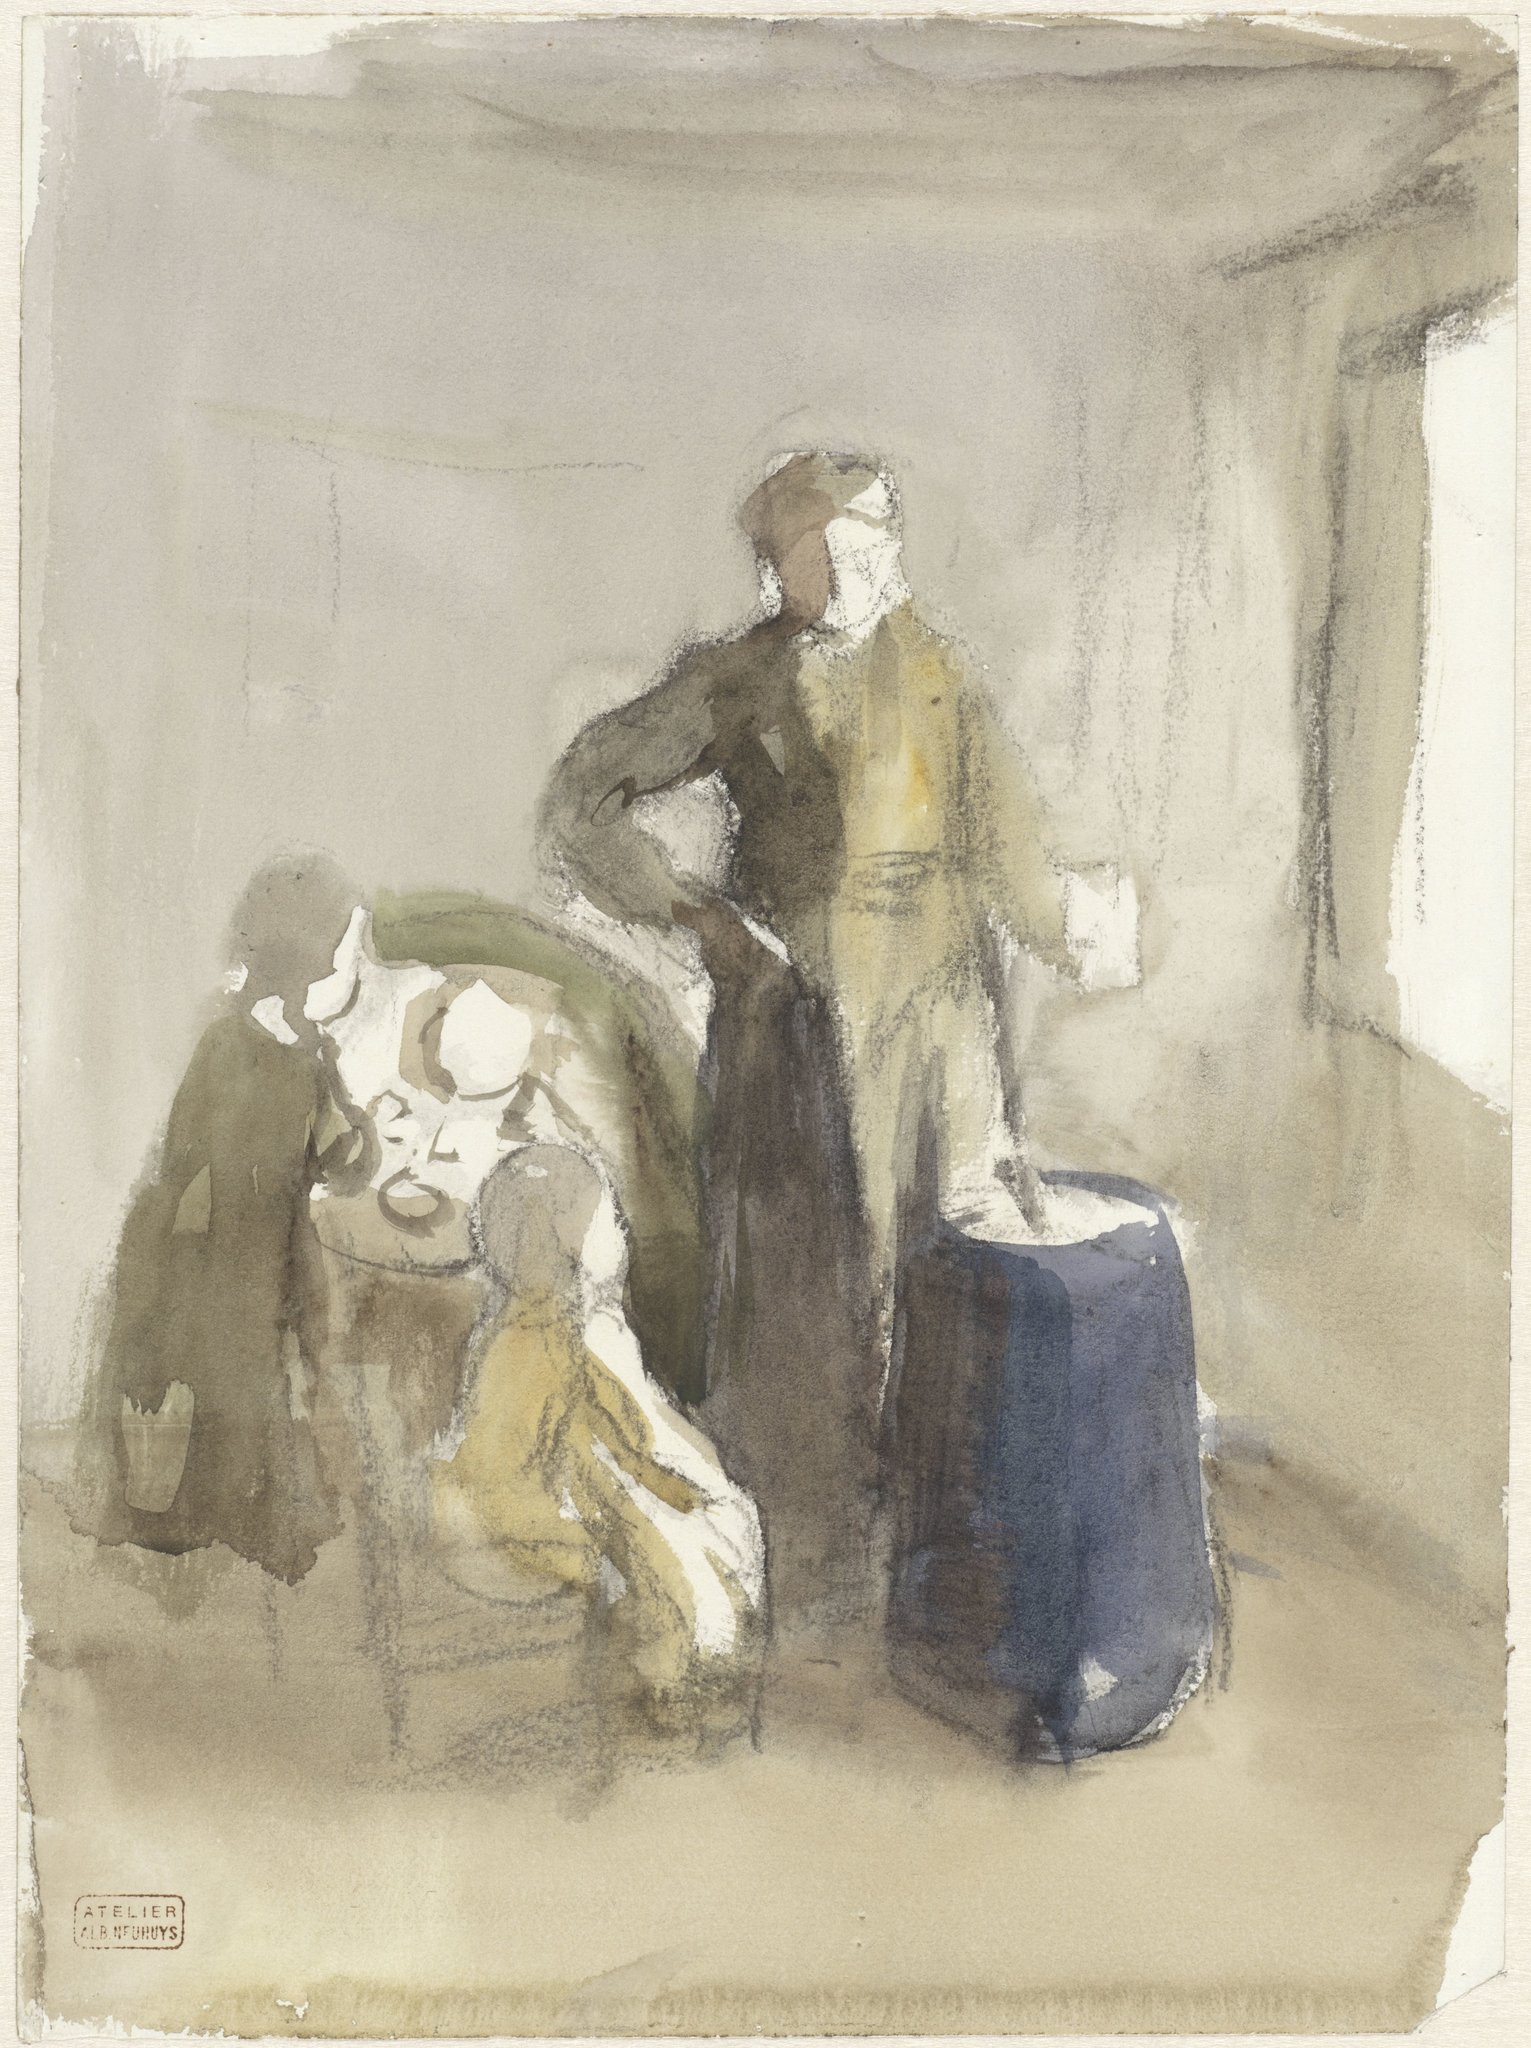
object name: watercolor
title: Interieur met vrouw en kinderen bij een karnton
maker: albert neuhuys (1844-1914)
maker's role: draughtsman, painter, print maker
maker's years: 1844-1914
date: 1854-1914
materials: chalk, paper, watercolor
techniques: brush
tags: mother and baby or young child, churning